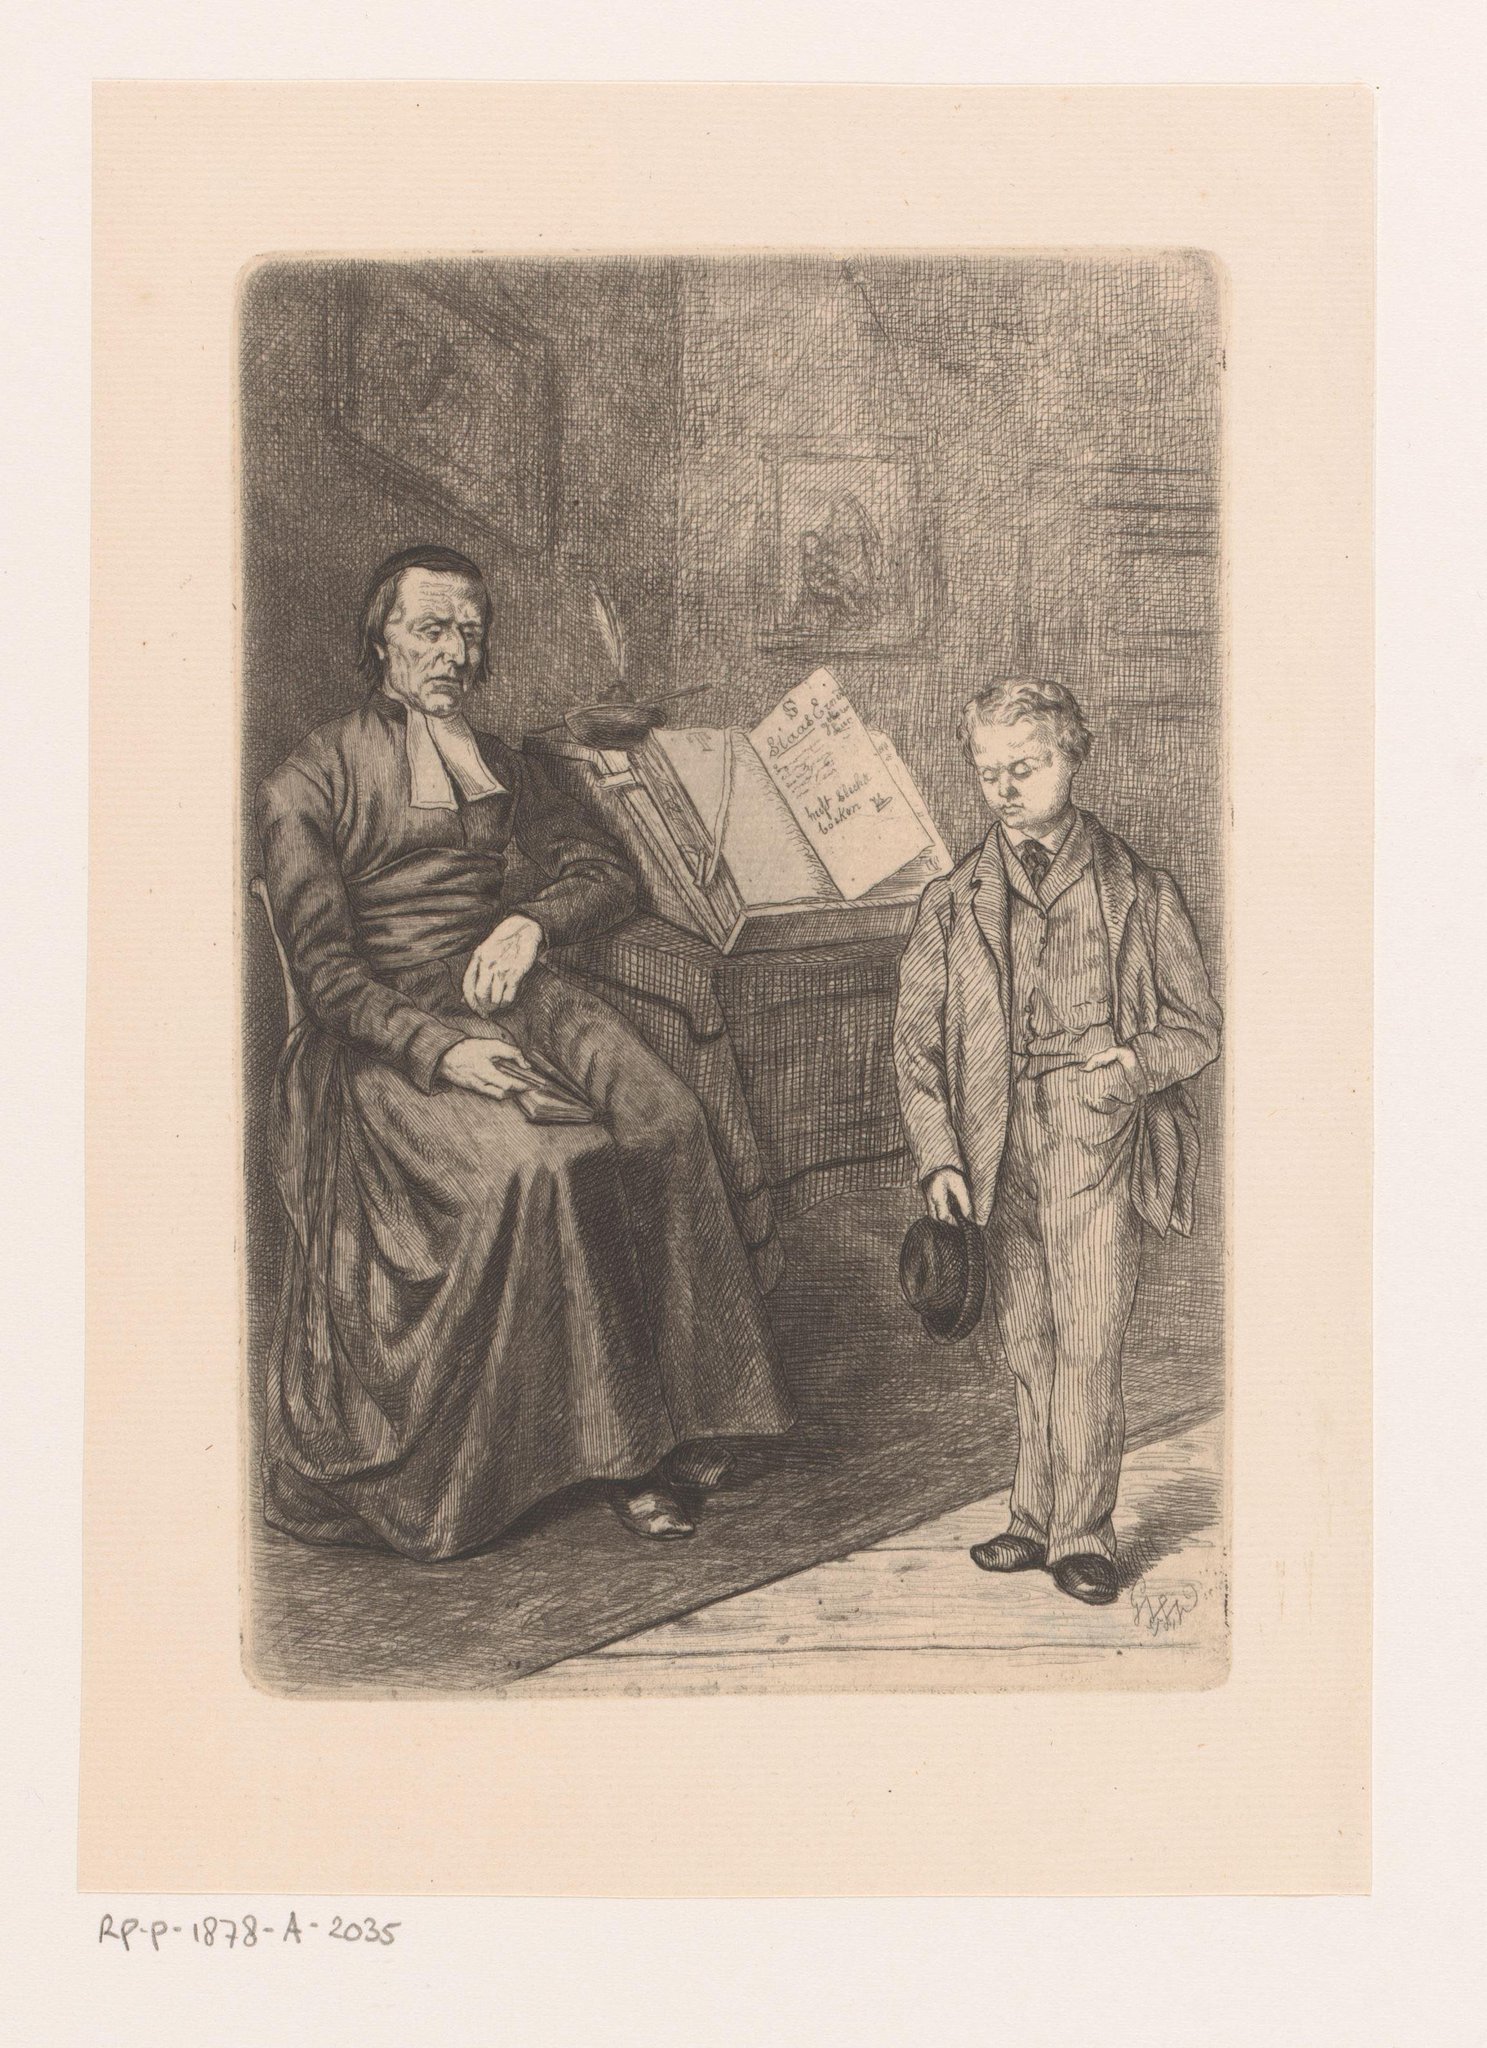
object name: print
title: Jongen met hoed in de hand staat voor een leraar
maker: willem geets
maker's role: print maker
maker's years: 1838-1919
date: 1872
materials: paper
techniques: etching, intaglio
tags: writing-table, writing-desk, teacher and pupil, book - mm - book open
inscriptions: collector's mark: Lugt 2228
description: Prent uit: Bergmann, Anton. Ernest Staas, advocaat: schetsen en beelden. Gent: Hoste, Den Haag: Martinus Nijhoff, [1874-1875].